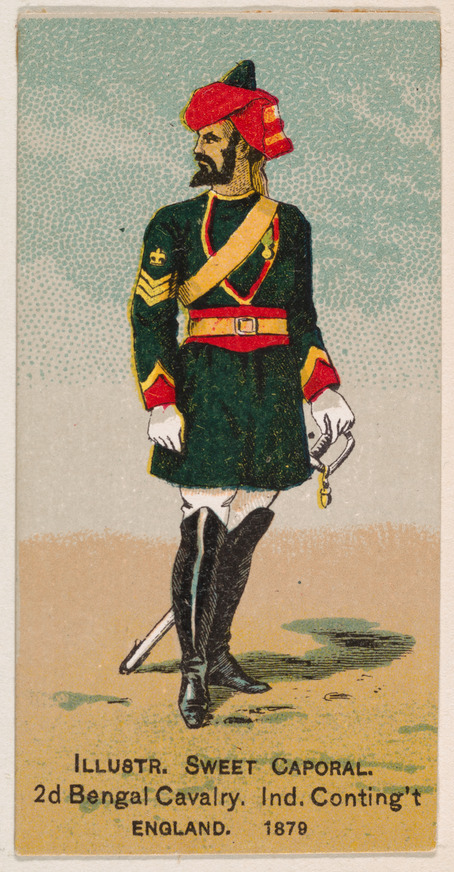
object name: print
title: 2nd Bengal Cavalry, Ind. Conting't, England, 1879, from the Military Series (N224) issued by Kinney Tobacco Company to promote Sweet Caporal Cigarettes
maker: kinney brothers tobacco company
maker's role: publisher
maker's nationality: american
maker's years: 1869-2011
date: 1888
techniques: color lithograph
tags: soldiers,men,profiles